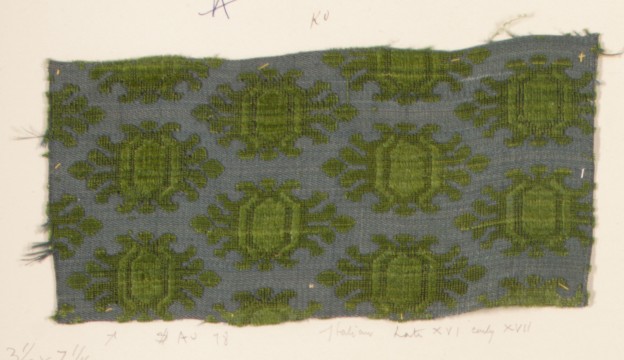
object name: fragment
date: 1567-1600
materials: silk